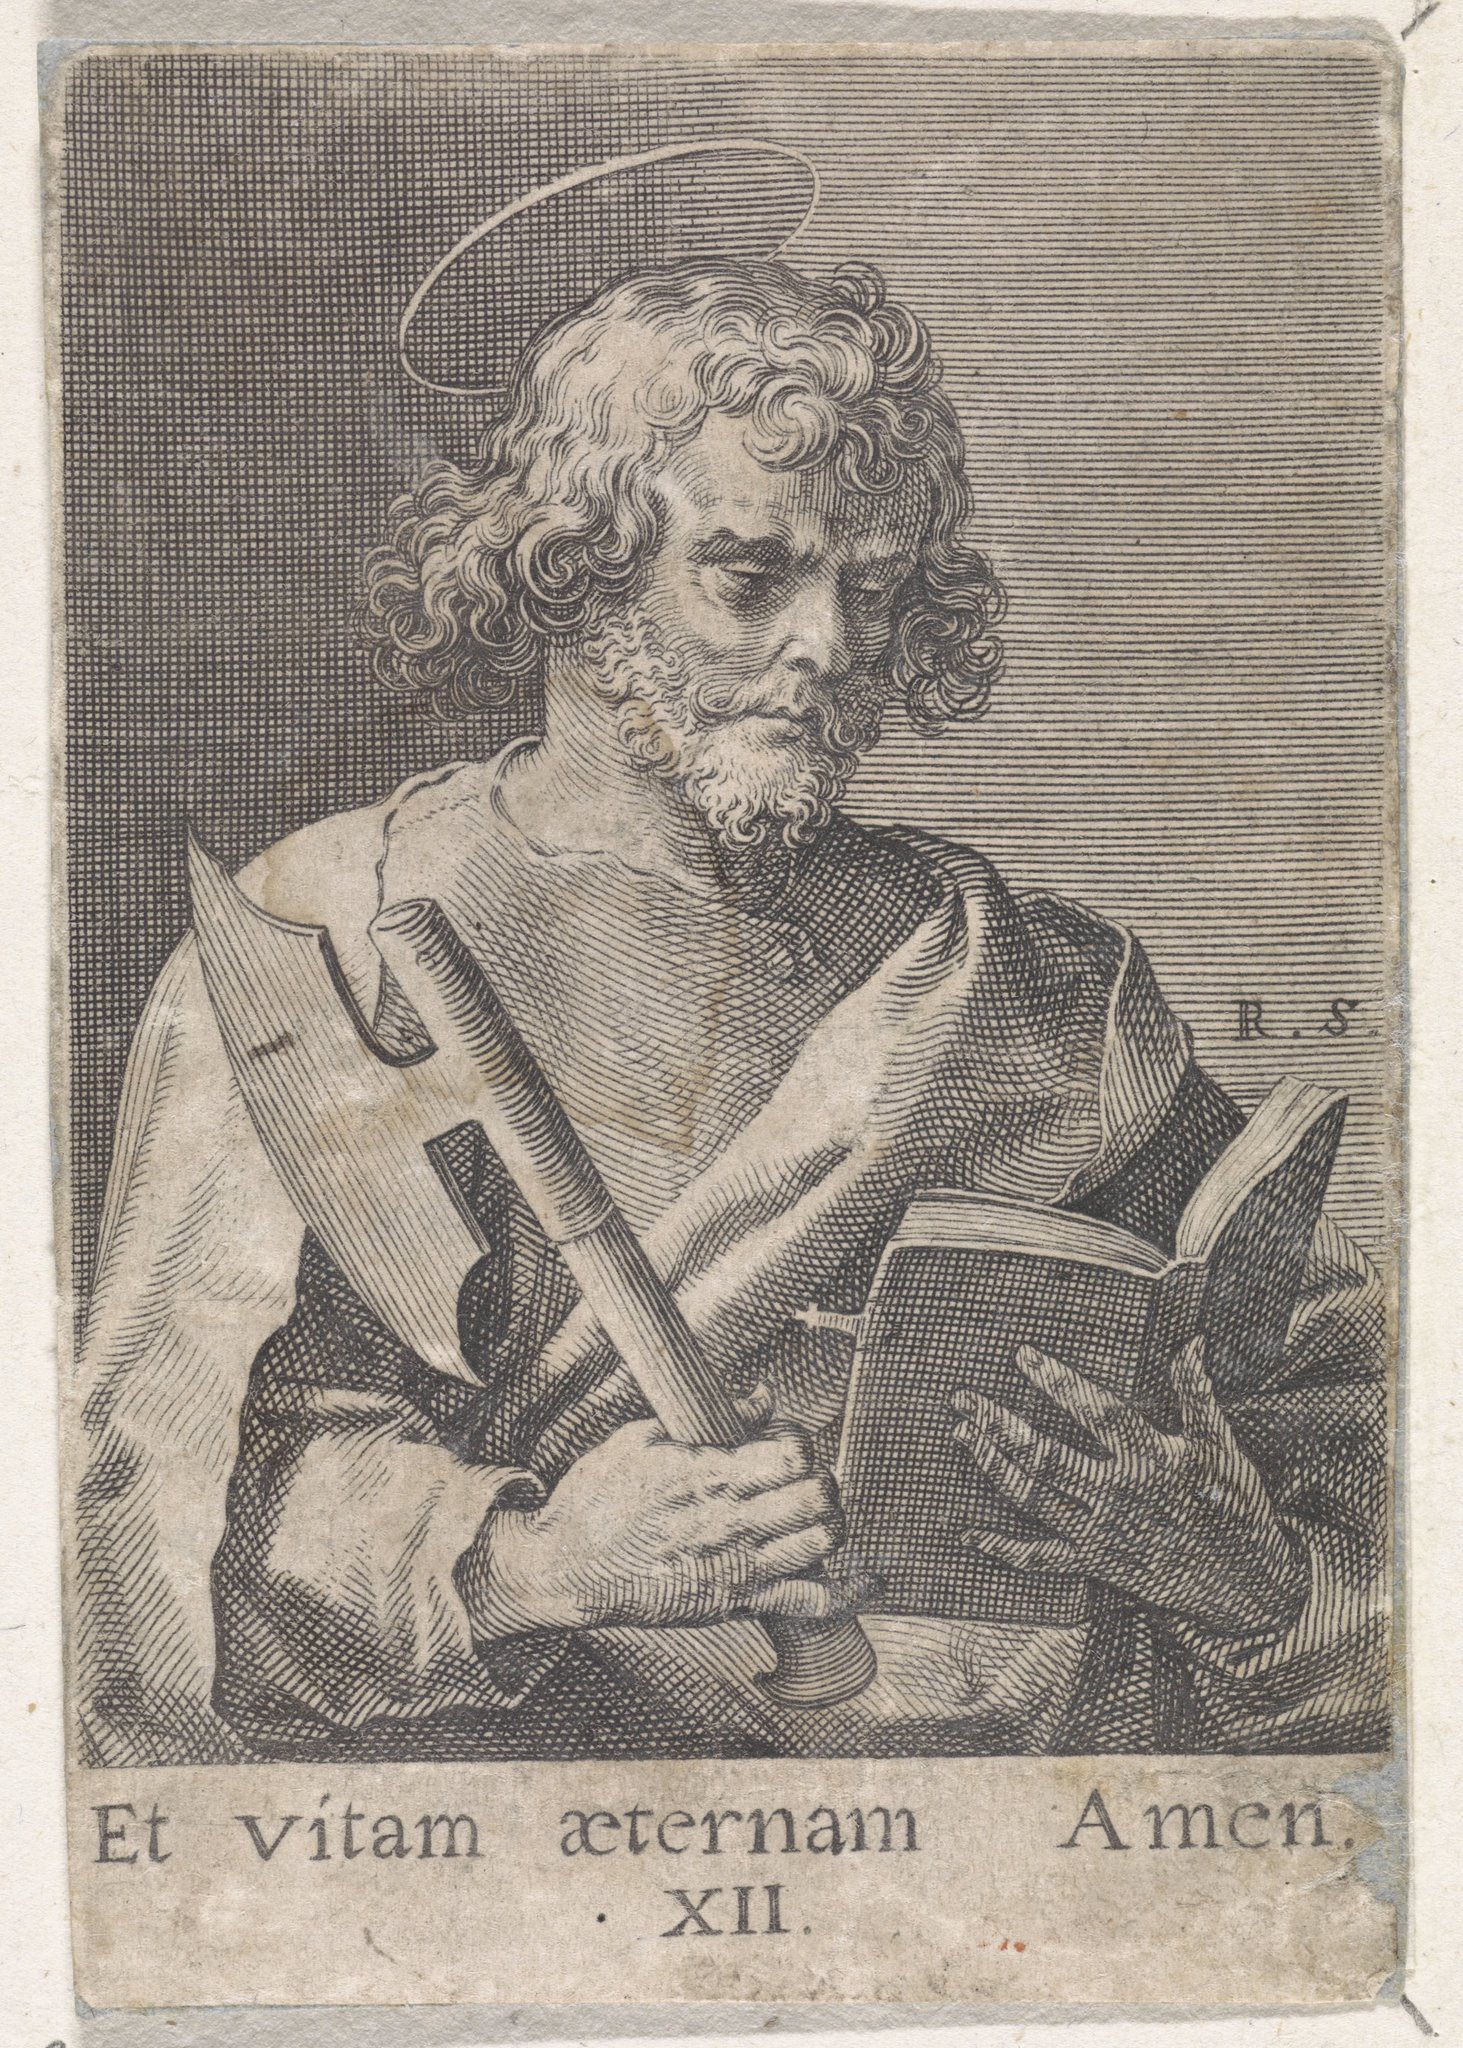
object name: print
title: Christus, Maria en de twaalf apostelen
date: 1570-1600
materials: paper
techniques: engraving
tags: the apostle and martyr matthias; possible attributes: axe, book, cross, halberd, scroll, sword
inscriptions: collector's mark: Lugt 240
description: De apostel Matthias, met als attribuut de handbijl. De prent heeft een Latijns onderschrijft met een regel uit het Credo. De laatste prent in een serie van veertien waarvan de prenten met een apostel genummerd zijn van 1 tot 12.